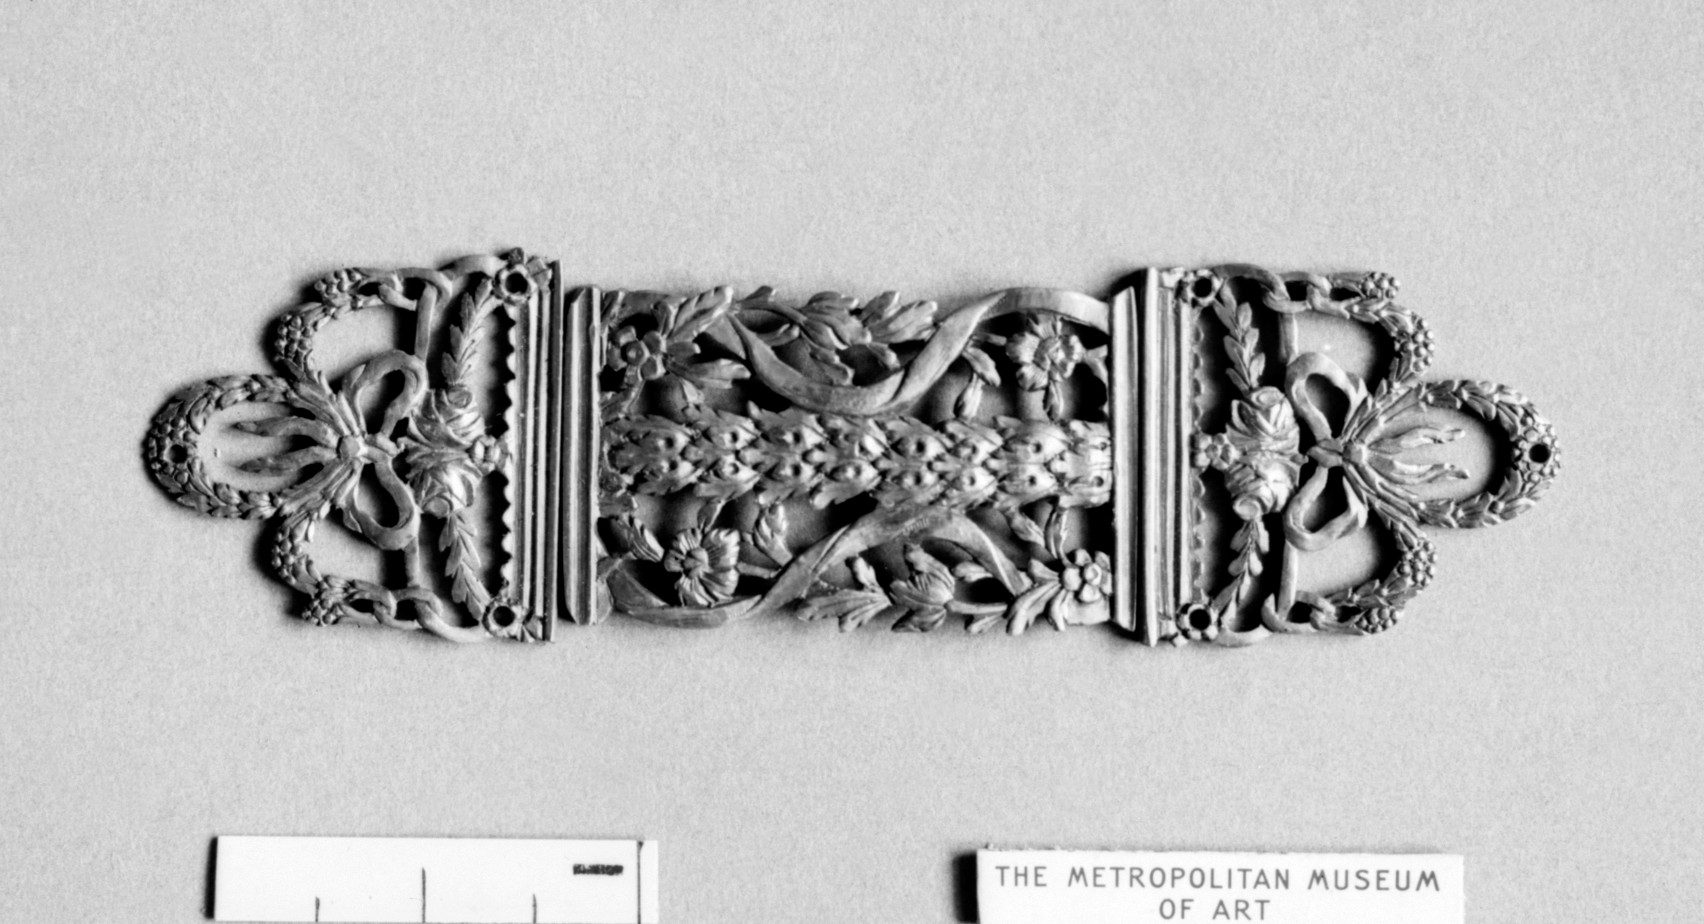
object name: book clasp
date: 1767-1800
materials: silver